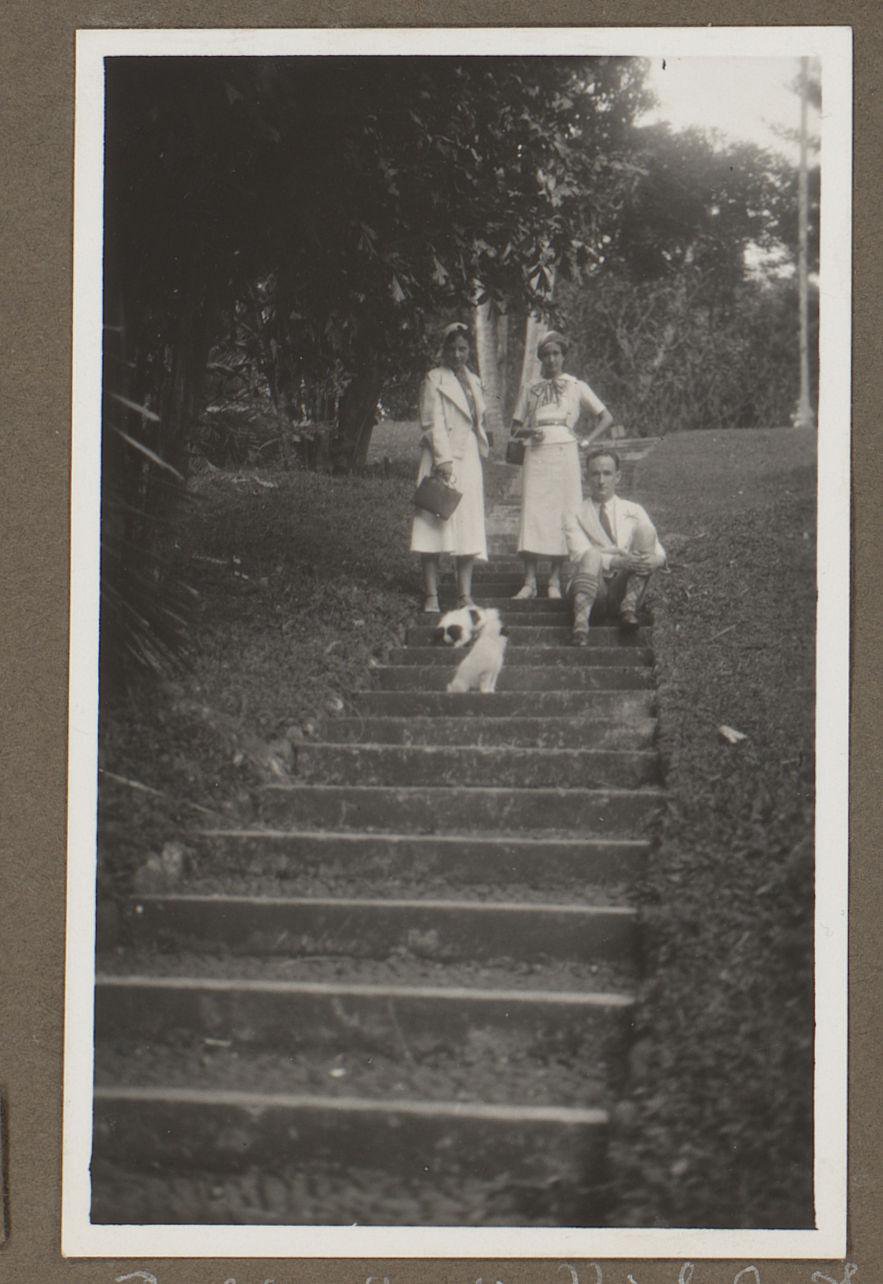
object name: album leaf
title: Dootje van Zijll de Jong met Bobby en een man in een park, Batavia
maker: Anonymous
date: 1933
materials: paper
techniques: gelatin silver print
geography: batavia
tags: amsterdam, park, batavia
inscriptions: inscription: ‘Bobby, Dootje Thiel G.H.’